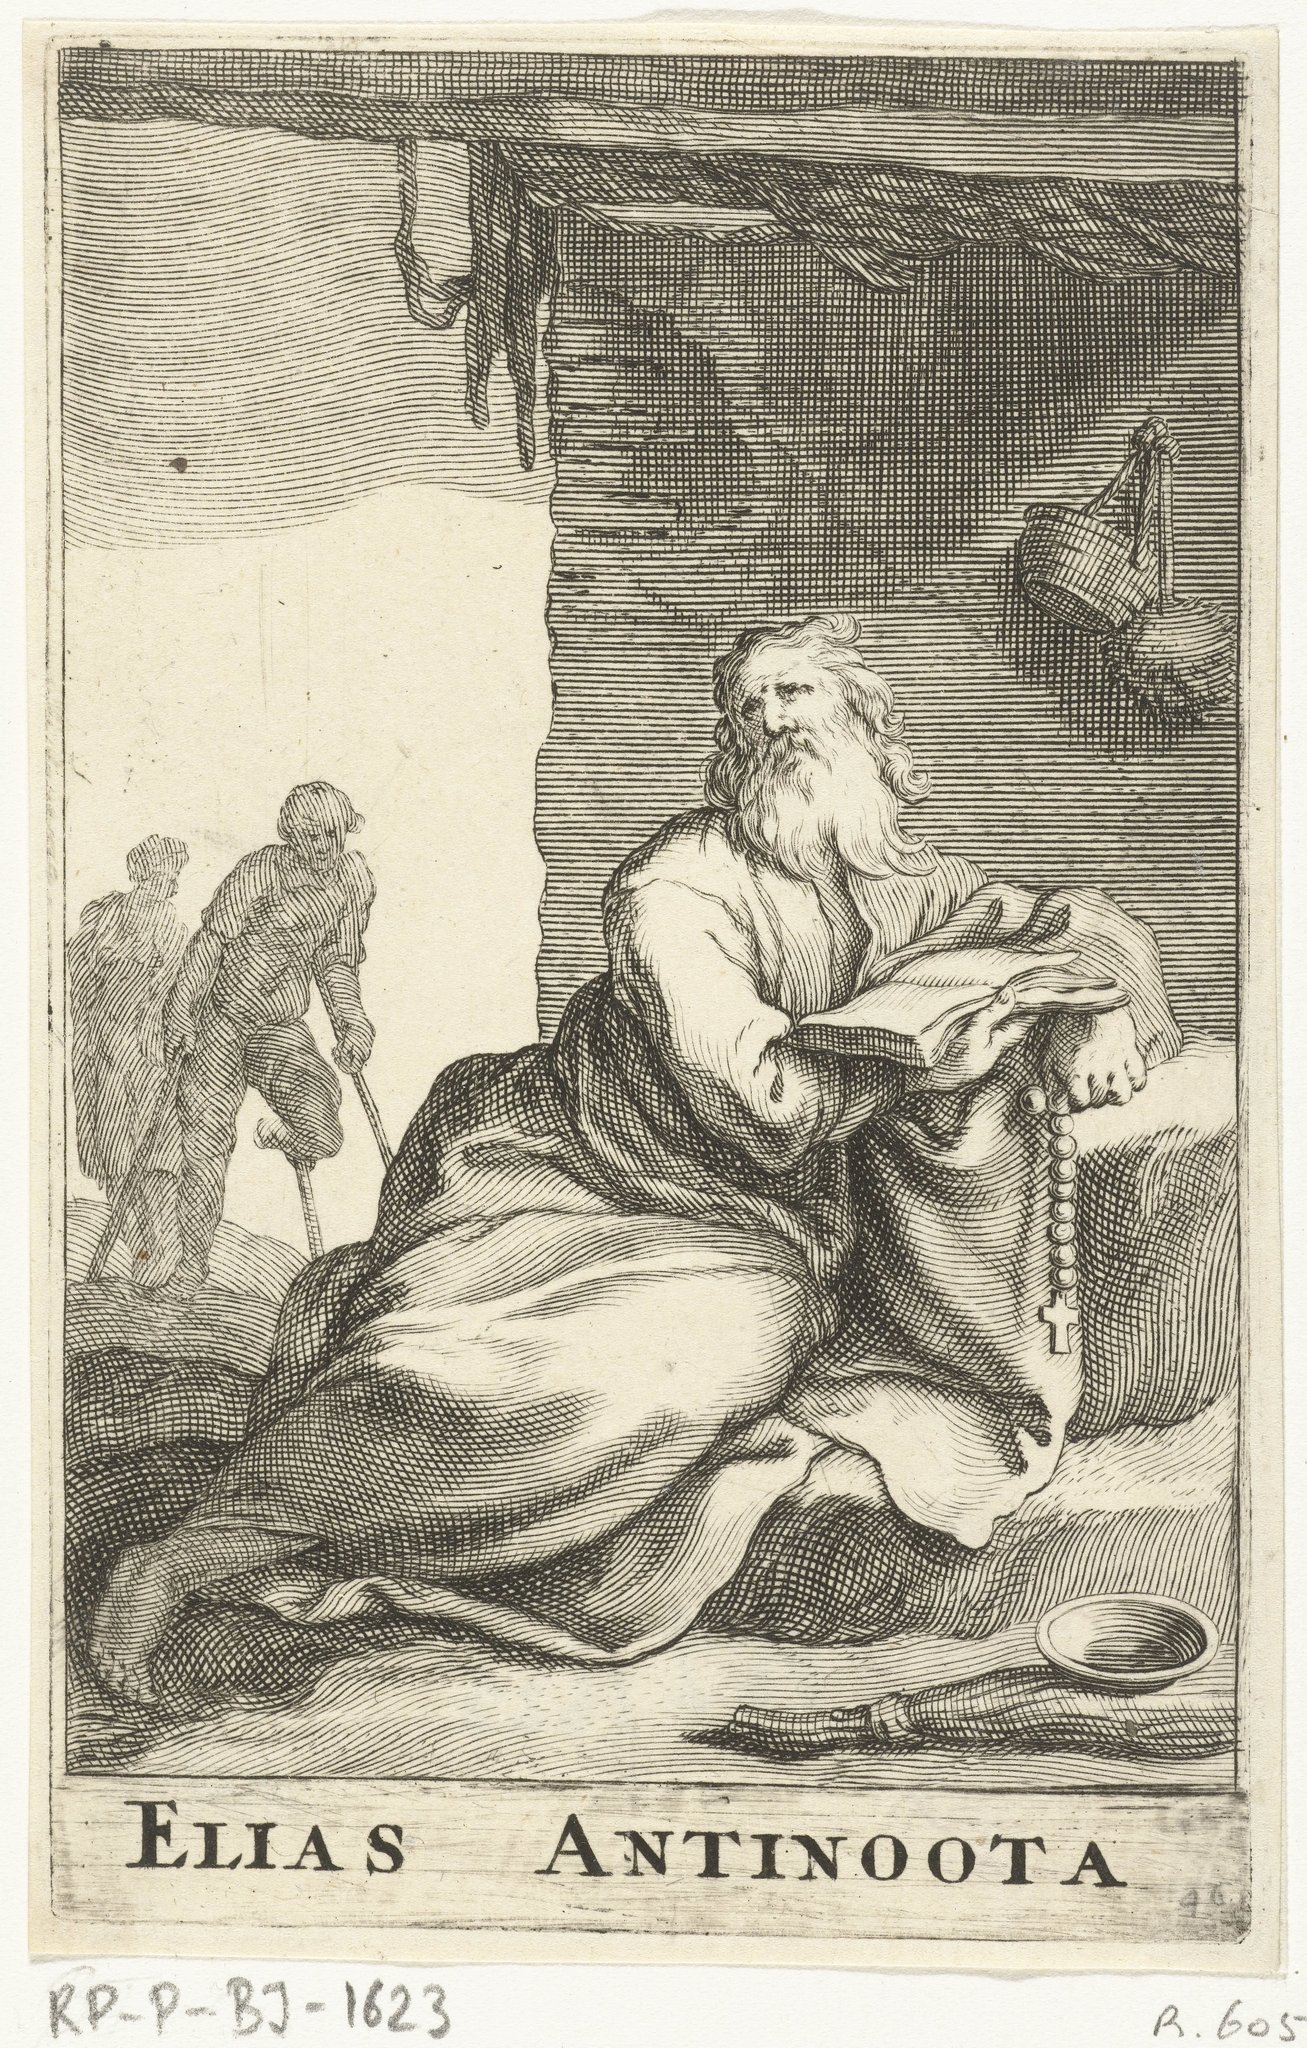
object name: print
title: Elias Antinoota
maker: frederick bloemaert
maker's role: print maker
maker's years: 1614-1669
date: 1636-1670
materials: paper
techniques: engraving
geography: utrecht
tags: male saints (with name), crutches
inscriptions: collector's mark: Lugt 240, number: ‘46’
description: De heilige Elias Antinous leunt zittend tegen een blok hout en heeft een boek en een rozenkrans in de handen. In de deuropening staan twee figuren waarvan één op krukken loopt. Prent uit een serie van 80 prenten en een titelprent met kluizenaars uit de 2e tot de 6e eeuw.